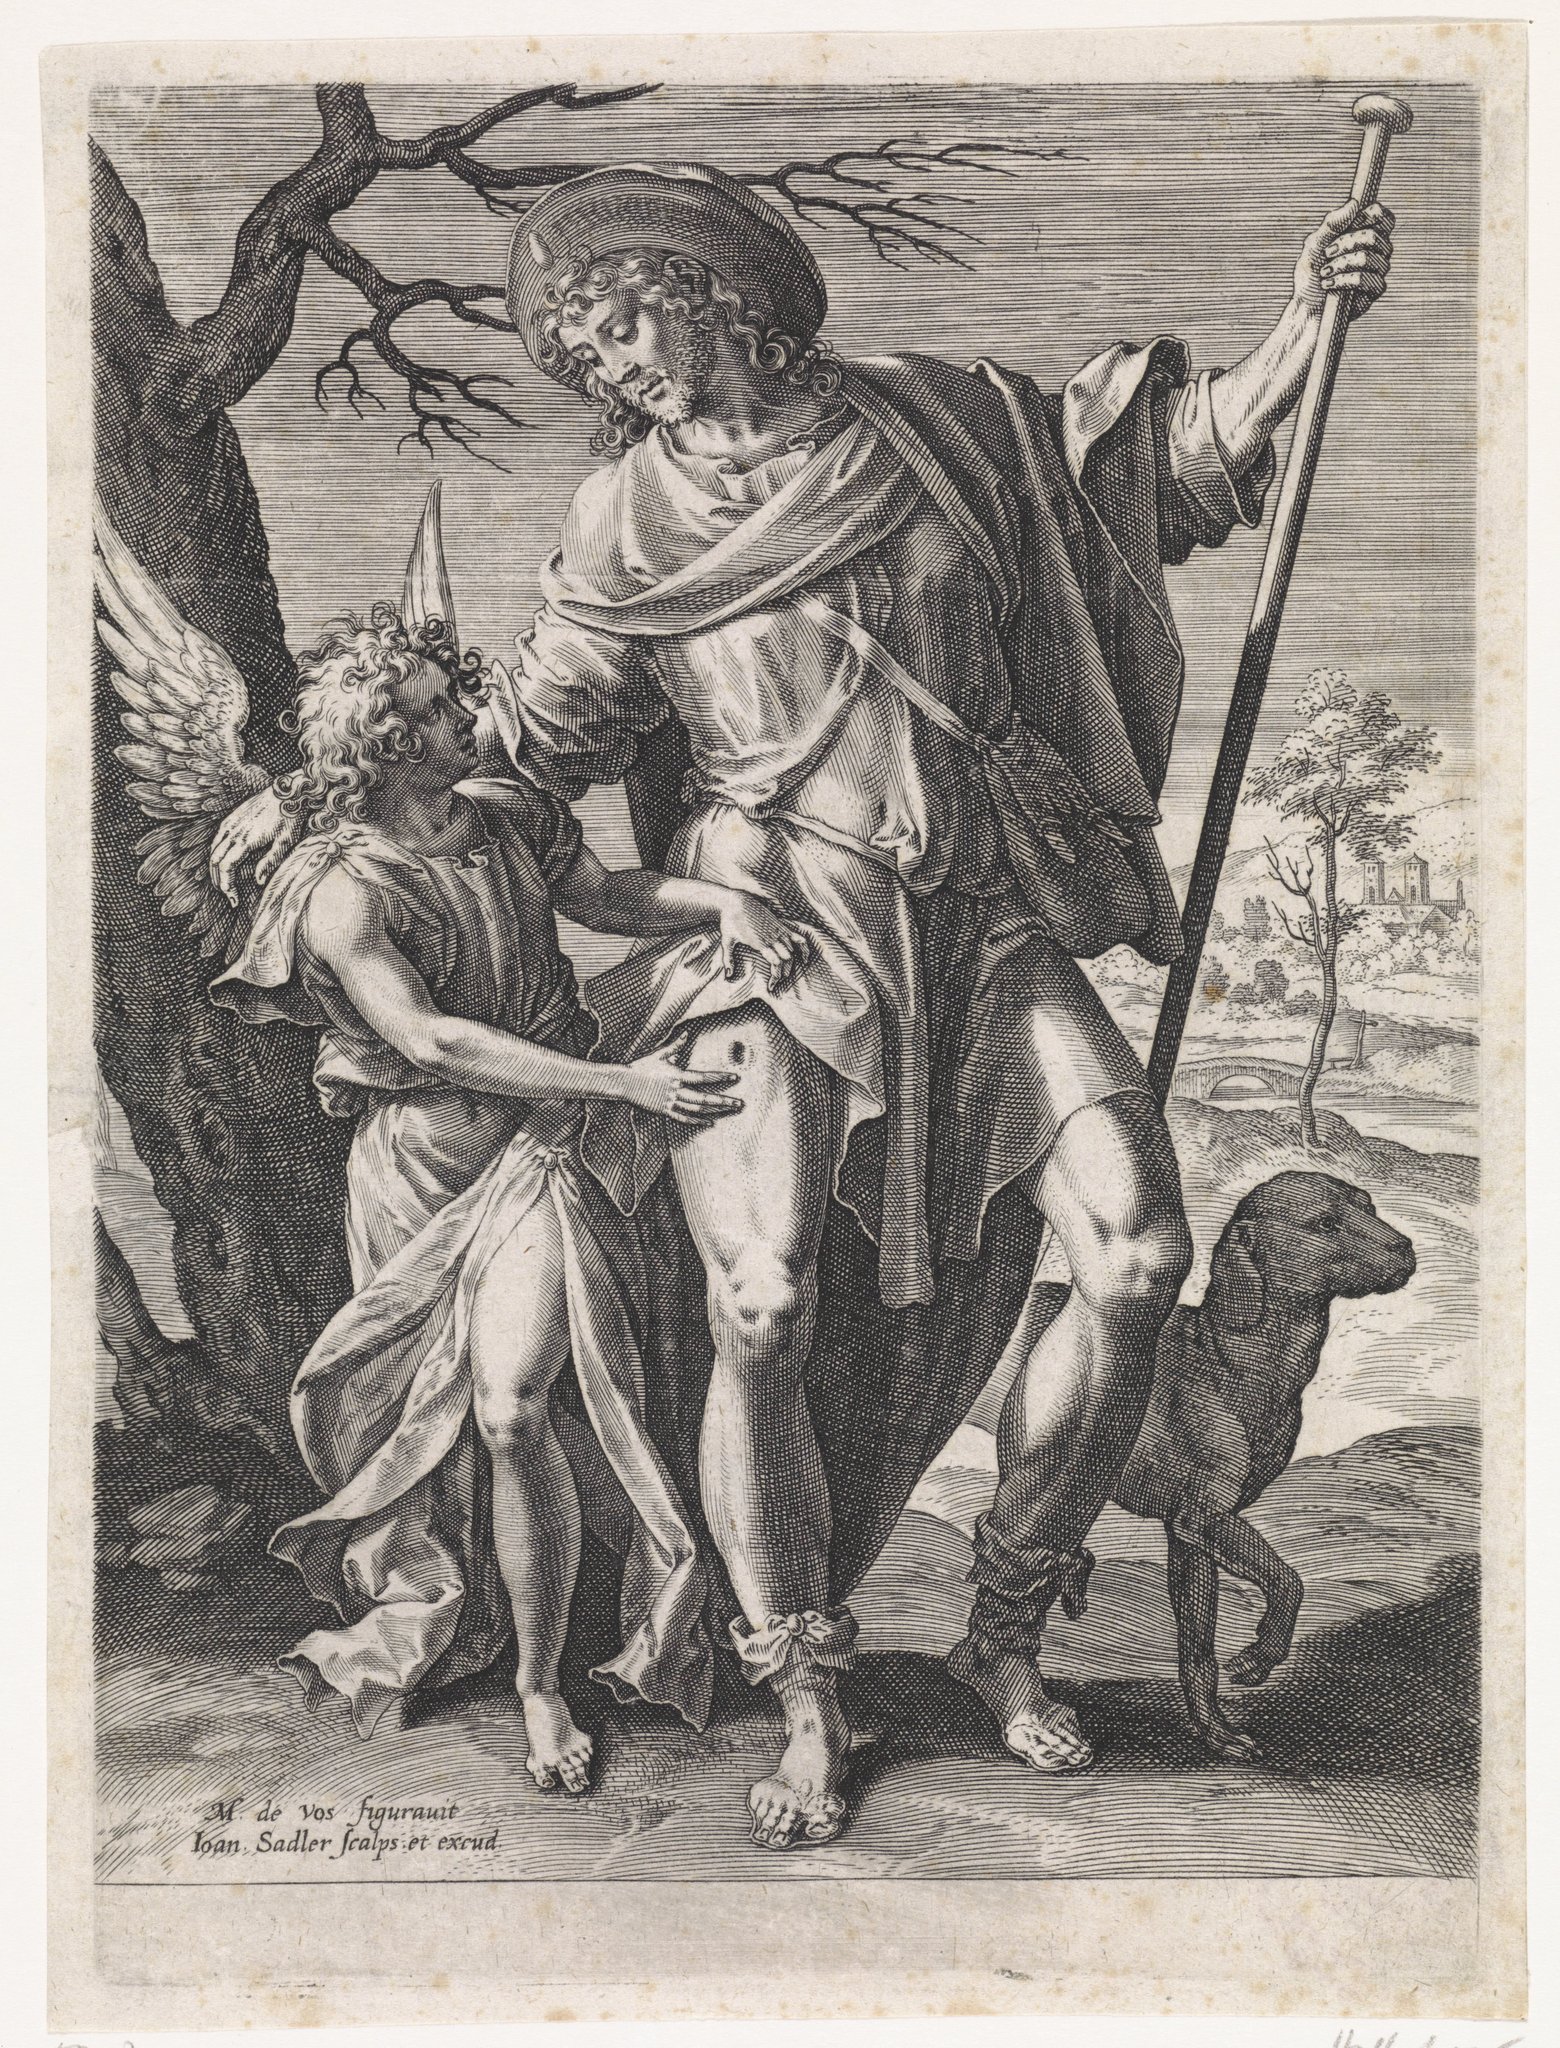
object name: print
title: Heilige Rochus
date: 1560-1586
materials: paper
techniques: engraving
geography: antwerp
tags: the confessor and pilgrim roch(us) (rocco, rock) of montpellier; possible attributes: angel (with ointment box or spoon), dog (sometimes with loaf), (pointing at) plague-spot on thigh, pilgrim's shell, staff, hat and wallet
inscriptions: collector's mark: Lugt 240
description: De H. Rochus als pelgrim. Een engel links van hem toont de zweer op H. Rochus zijn rechterbeen. Rechts een hond.